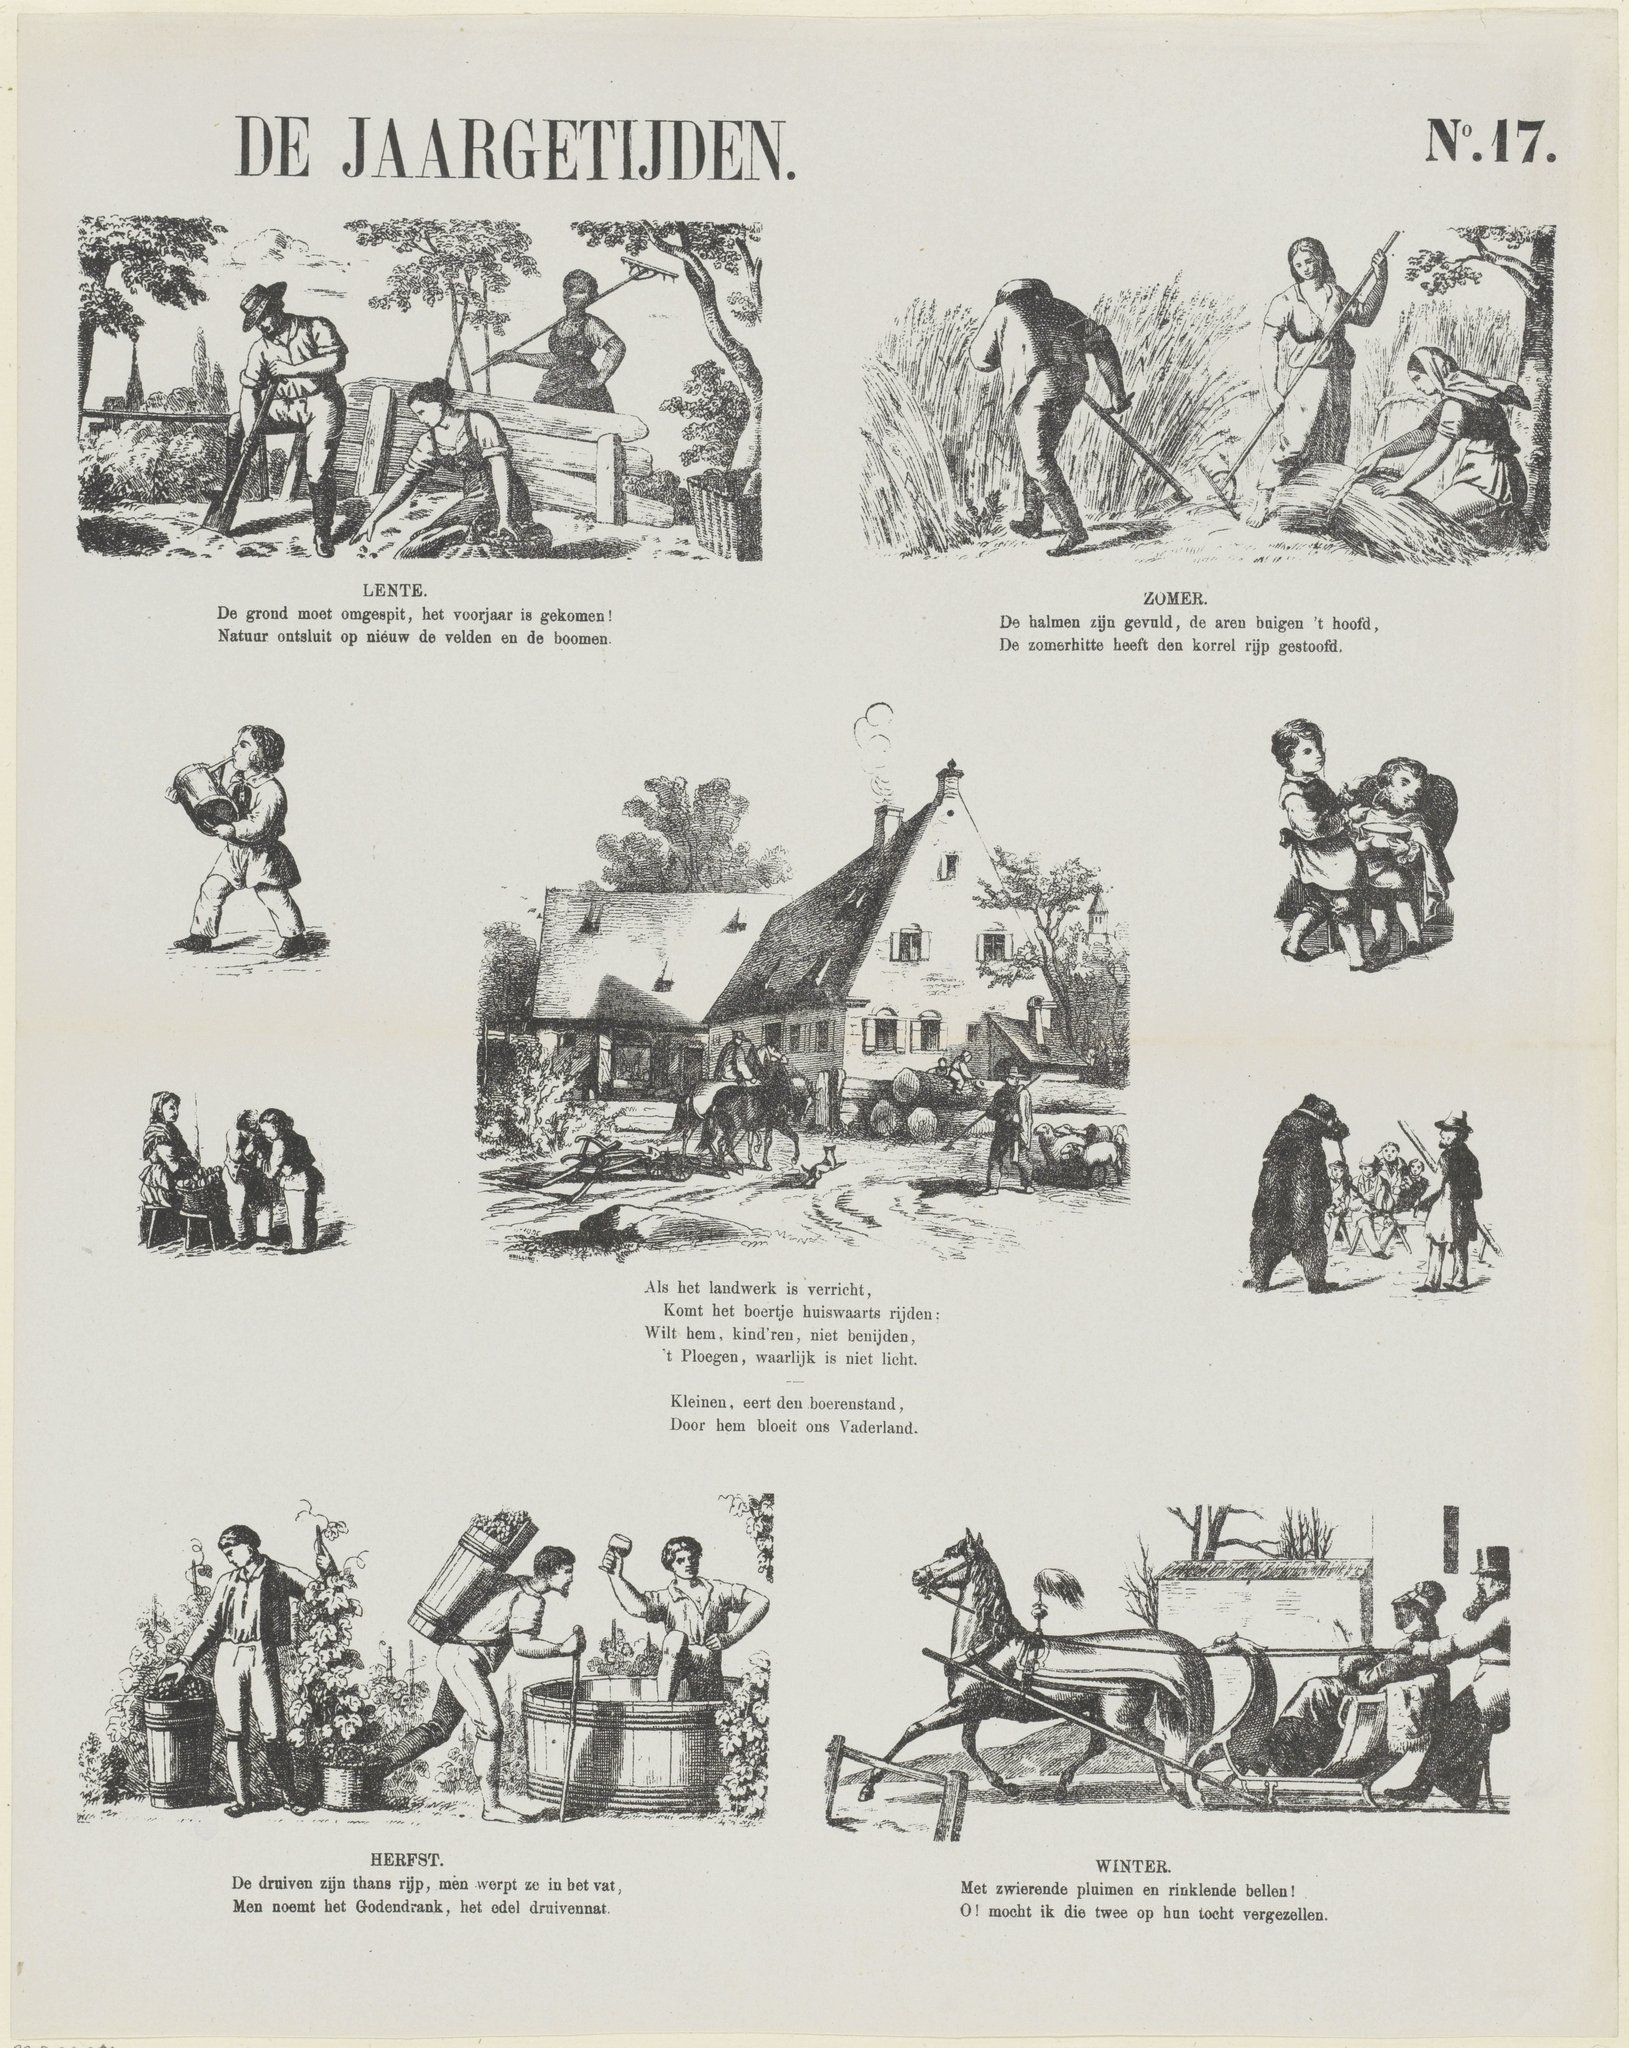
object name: print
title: De jaargetijden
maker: Anonymous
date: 1873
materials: paper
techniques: letterpress printing, lithograph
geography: amsterdam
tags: children's games and plays, earning money with bear, the four seasons of the year ~ human activities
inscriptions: collector's mark: Lugt 2760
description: Blad met 9 voorstellingen van de vier jaargetijden, spelende kinderen en een berentemmer. Onder enkele afbeeldingen een onderschrift. Genummerd rechtsboven: No. 17.